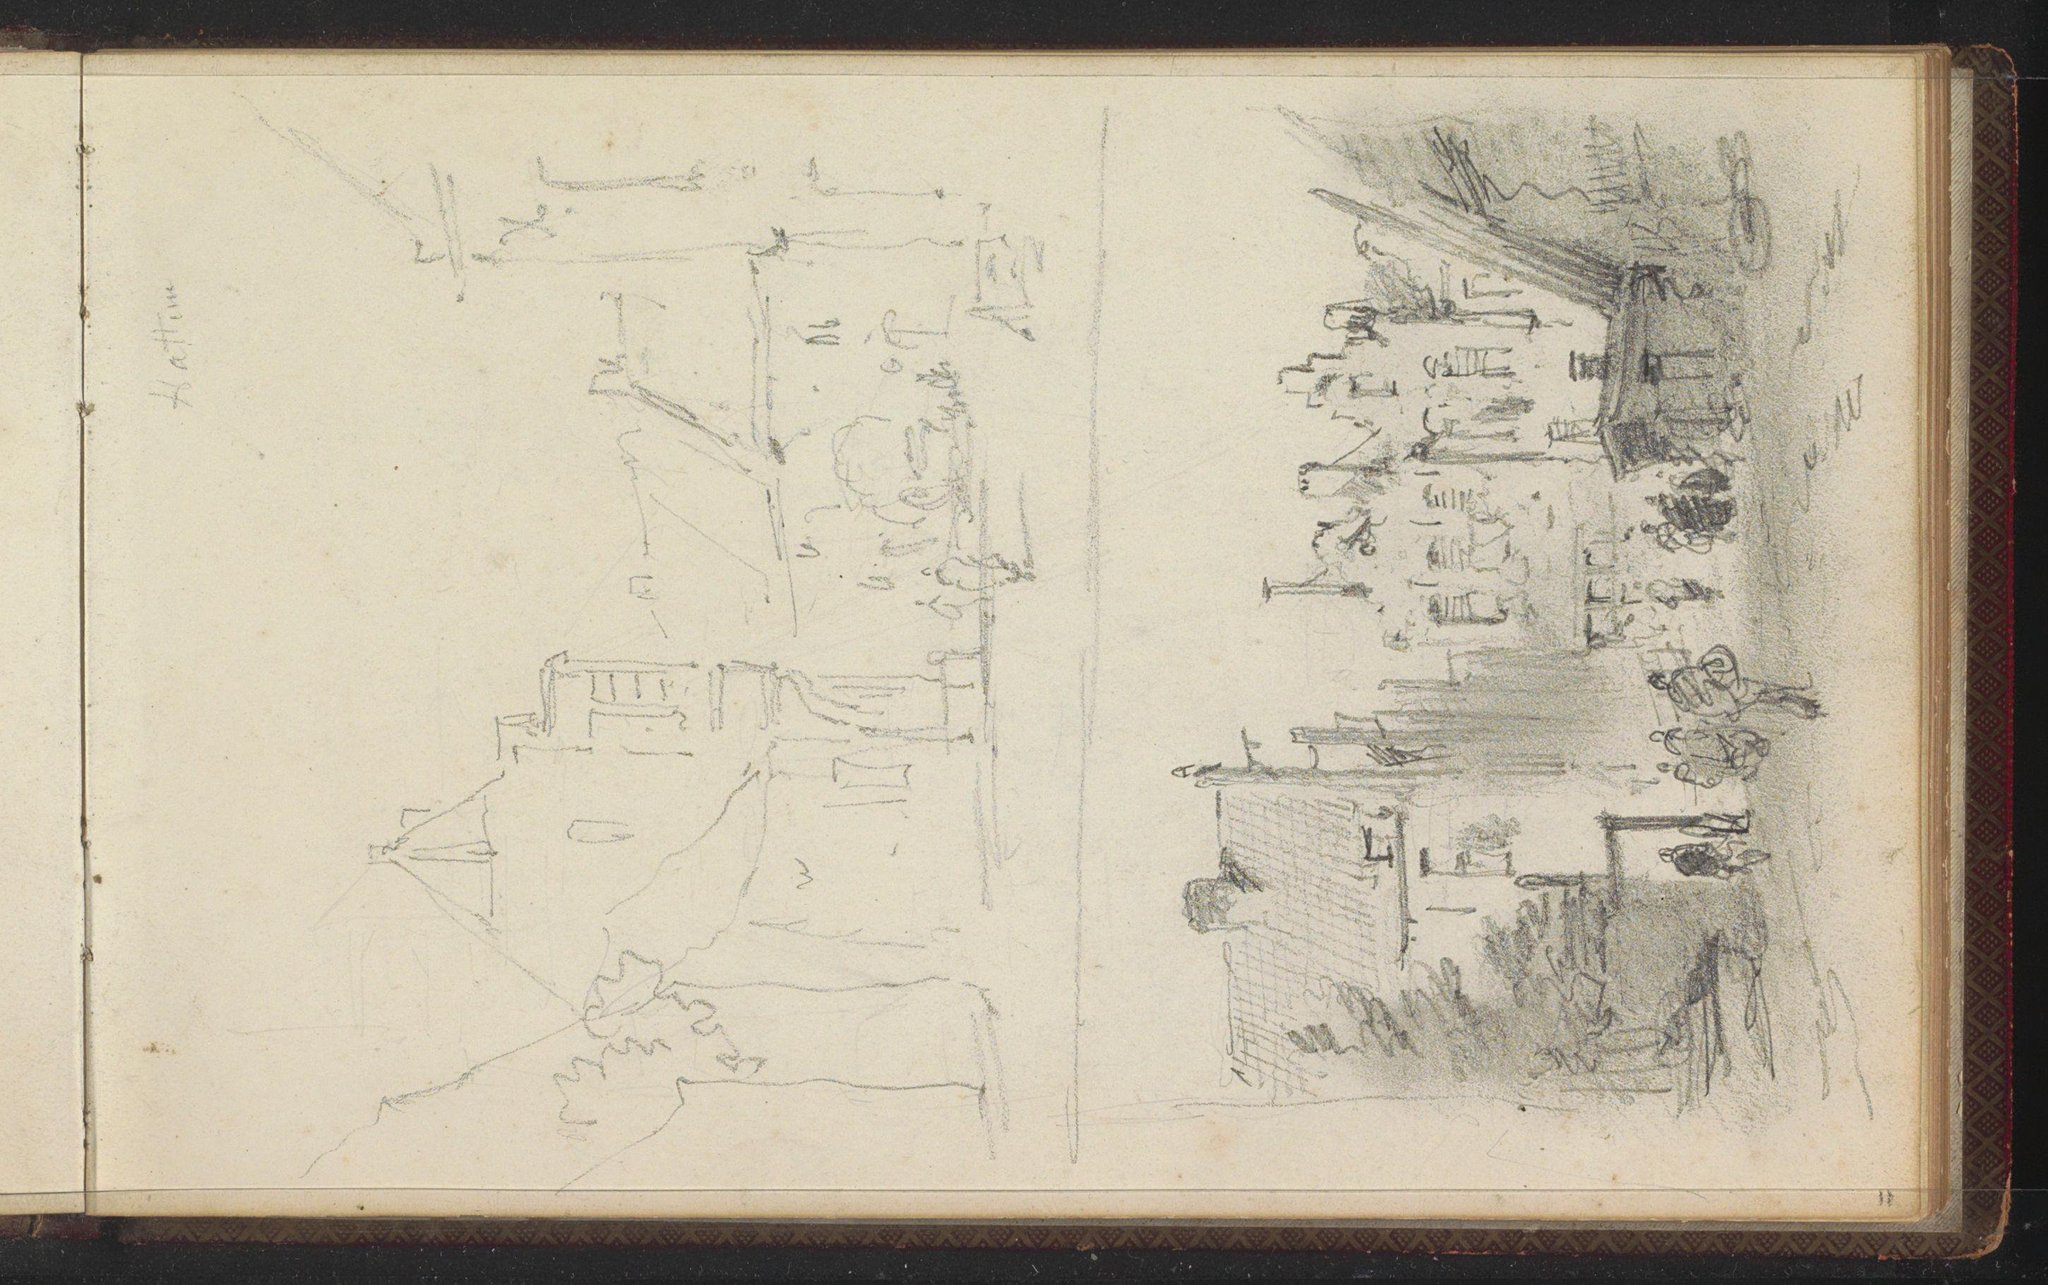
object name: sketchbook leaf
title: Twee stadsgezichten, Hattem en een onbekende stad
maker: adrianus eversen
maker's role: draughtsman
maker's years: 1818-1897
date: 1828-1897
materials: paper, pencil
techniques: stumping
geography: hattem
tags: street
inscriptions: annotation: ‘Hattem’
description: Boven een gezicht op een straat in Hattem met figuren. Onder een gezicht op een straat of plein in een onbekende stad, mogelijk ook Hattem. Blad 11 recto uit een schetsboek met 52 bladen vervaardigd in de omgeving van Kampen, Hattem, Hoorn en Zwolle.